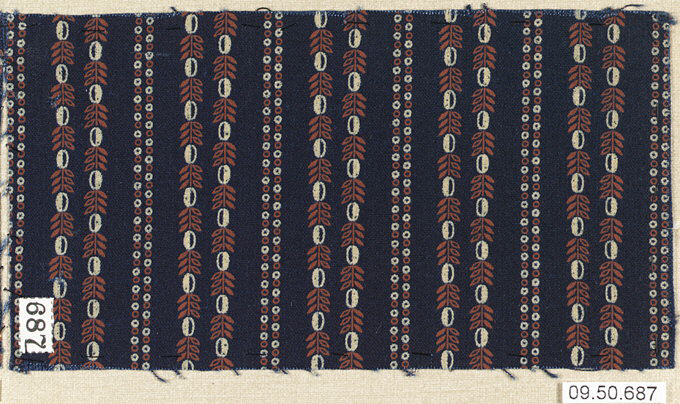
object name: piece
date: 1801-1900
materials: cotton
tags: leaves